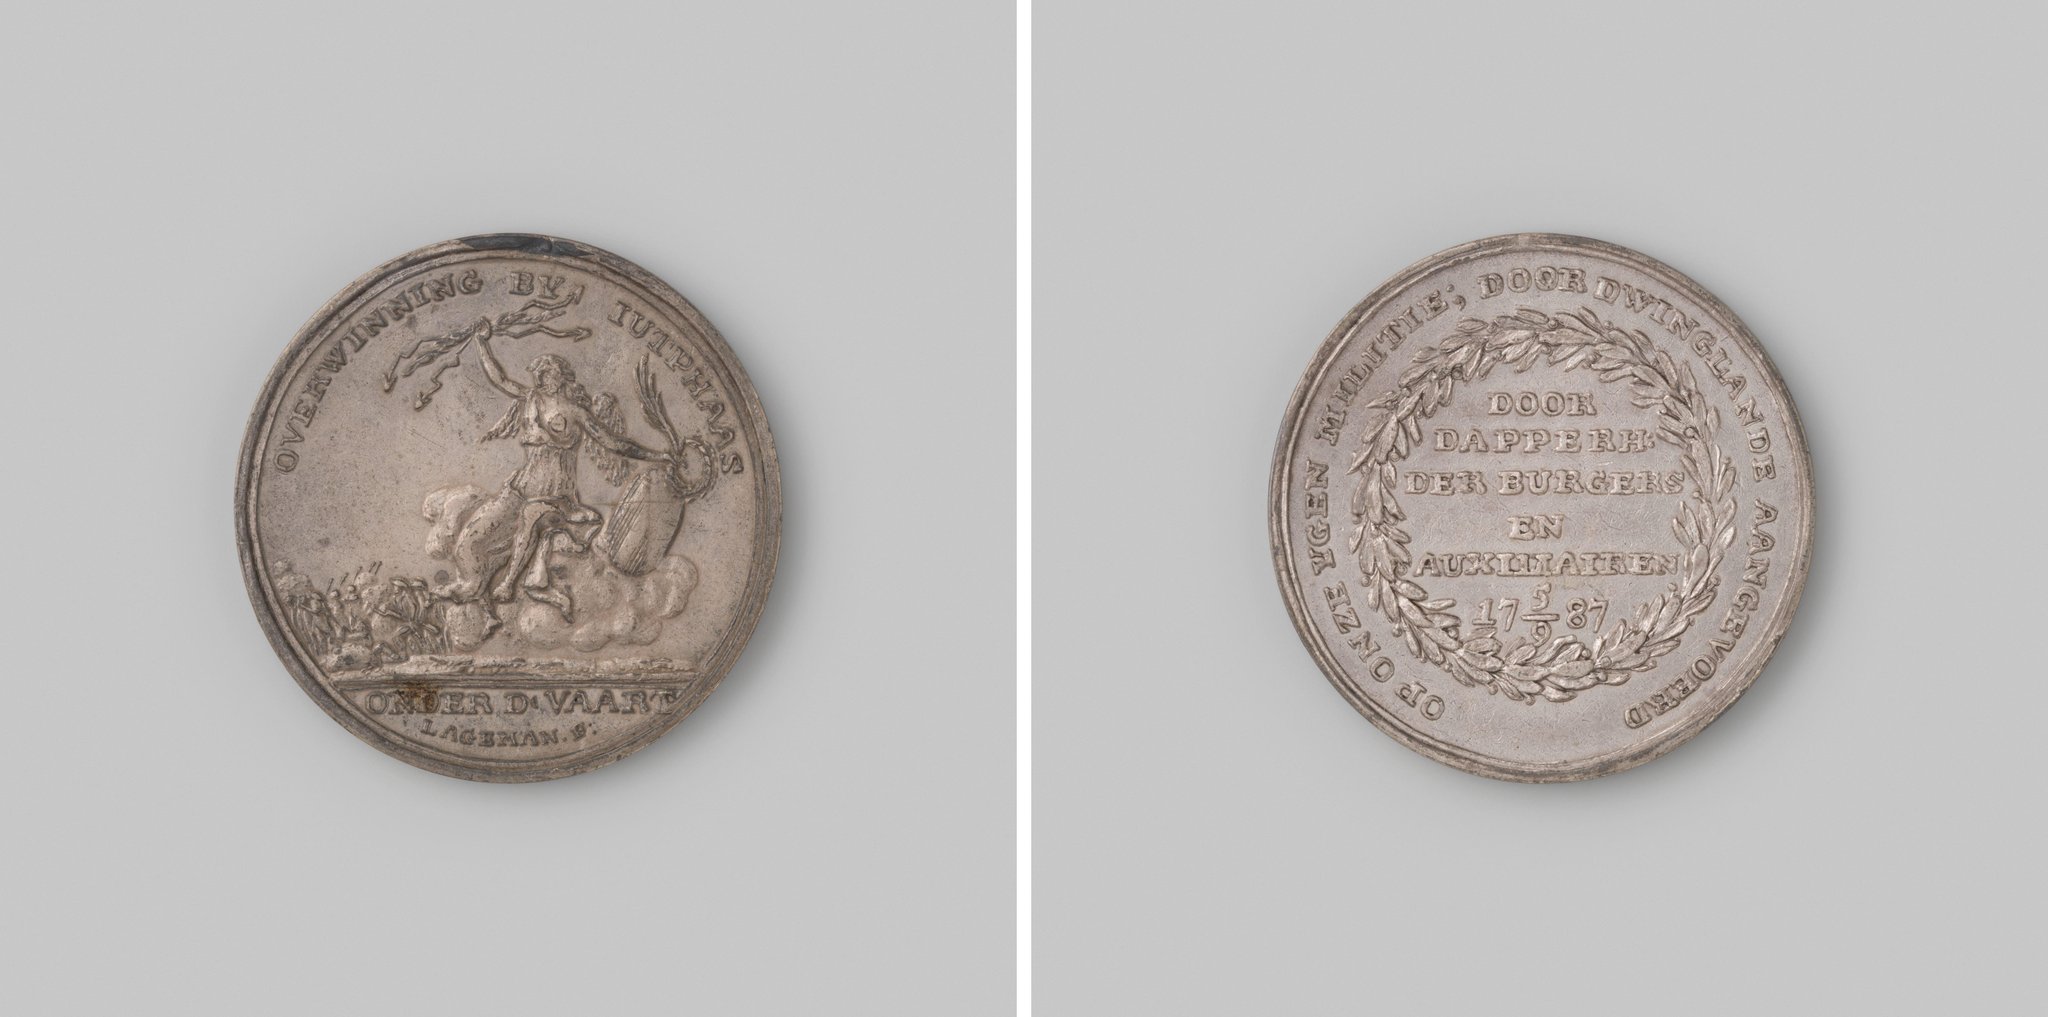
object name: history medal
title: Op het gevecht aan de vaart bij Jutphaas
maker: johannes michiel lageman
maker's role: silversmith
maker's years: 1735-1809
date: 1787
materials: silver